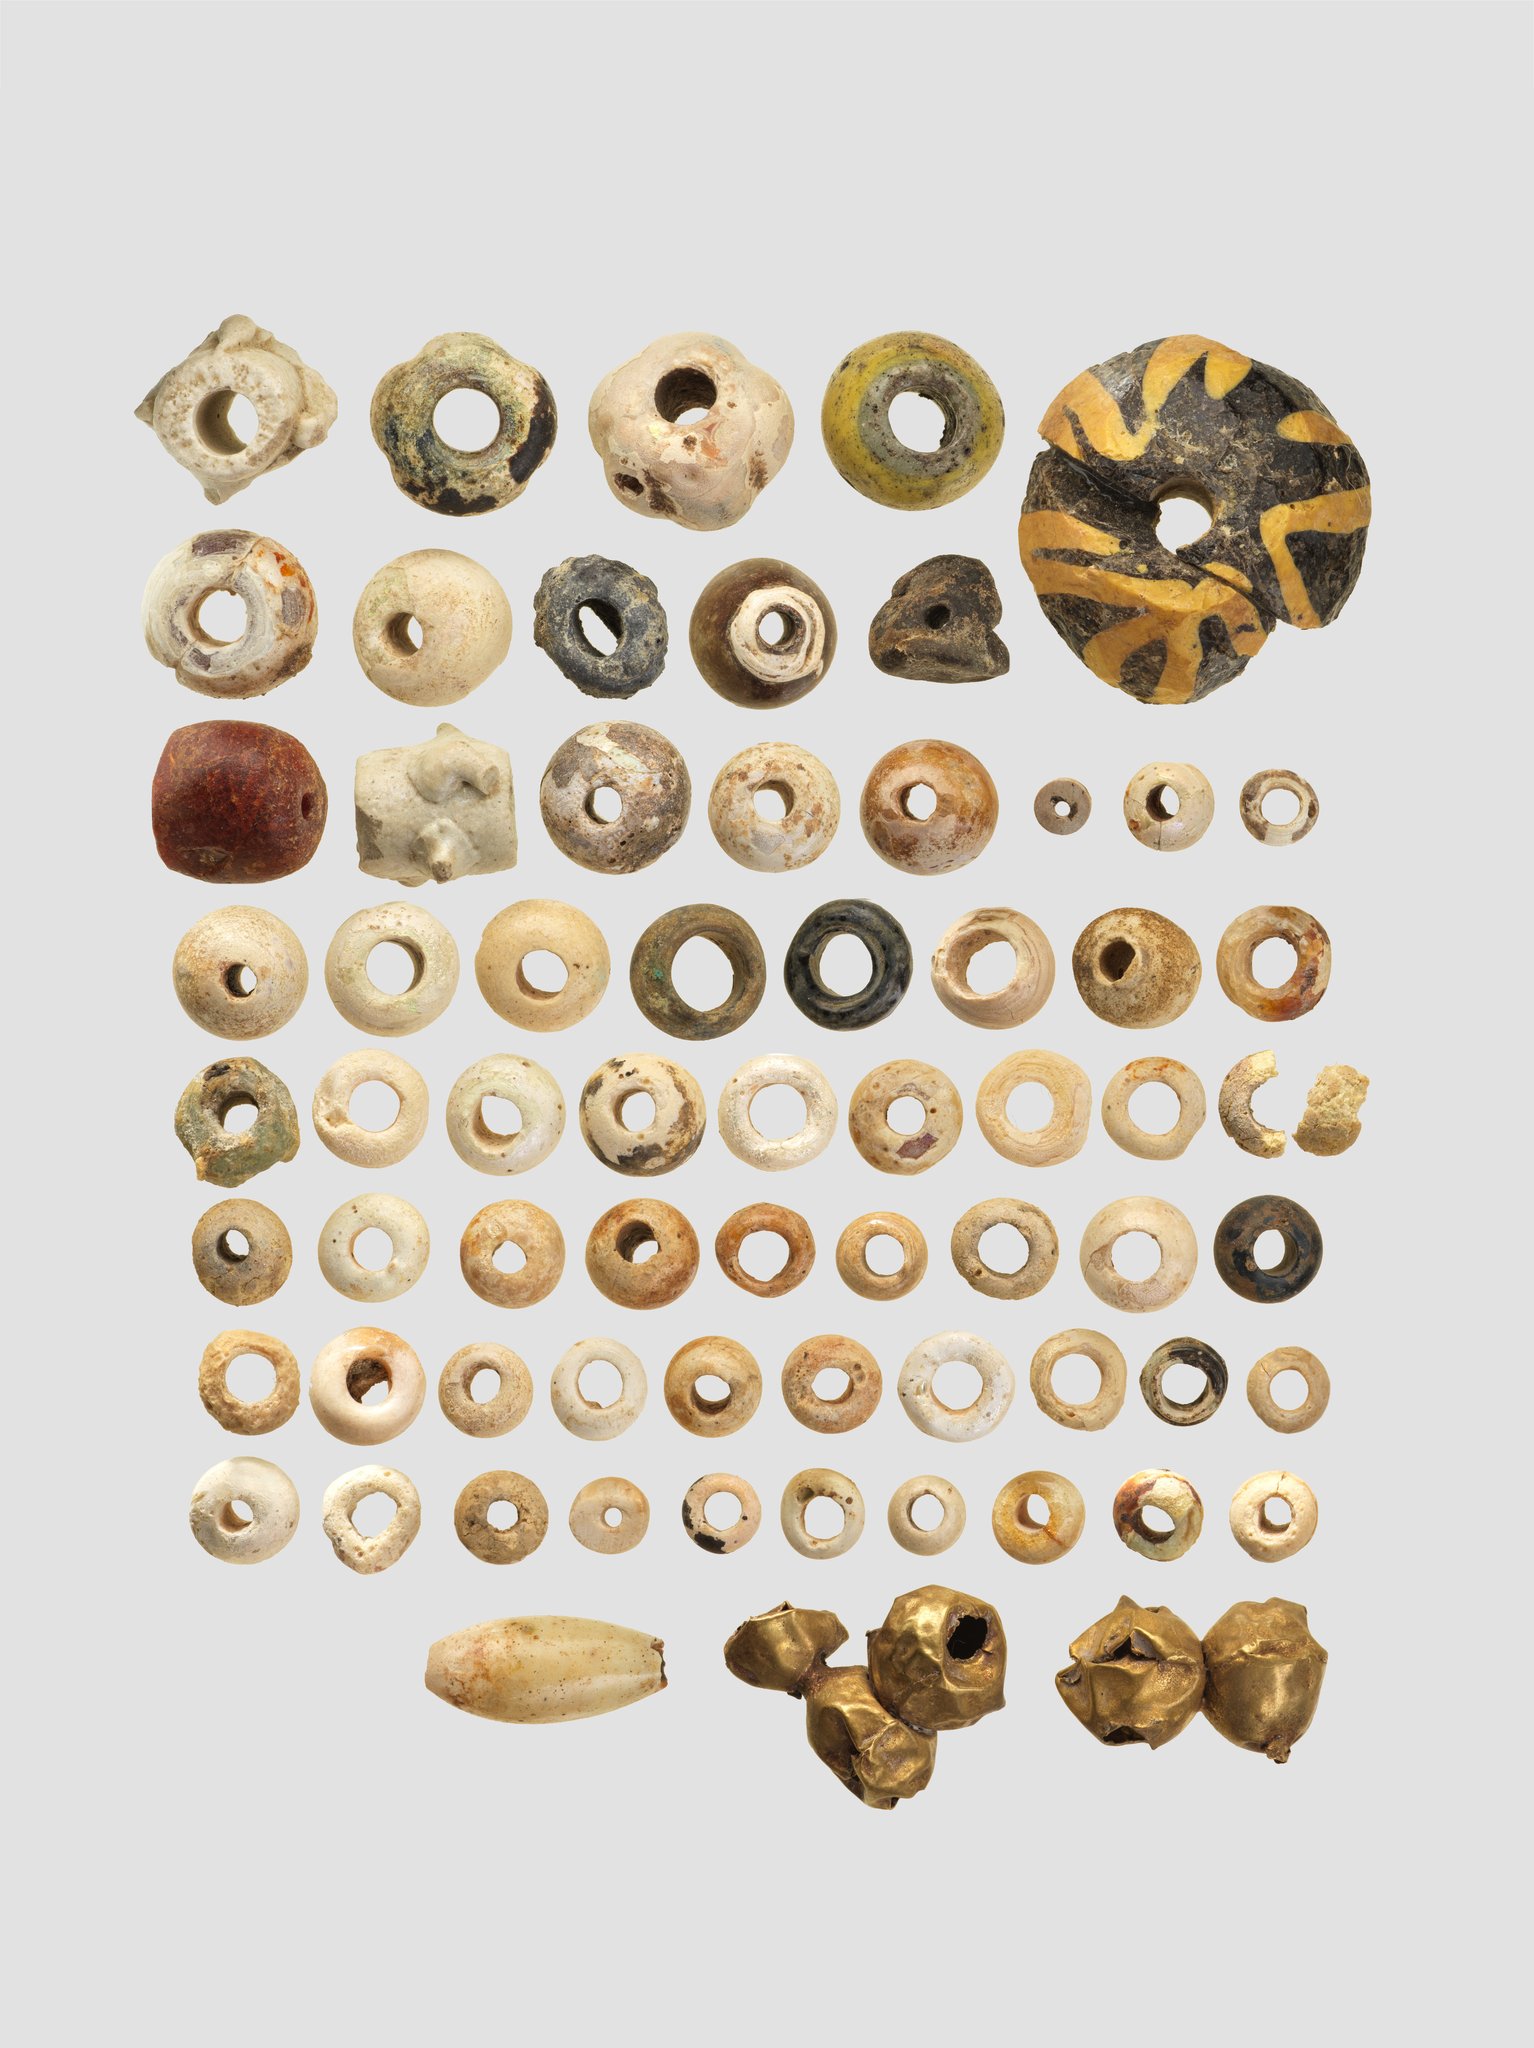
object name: bead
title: Beads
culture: iranian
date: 900-801 BCE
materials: glass, gold, stone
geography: iran